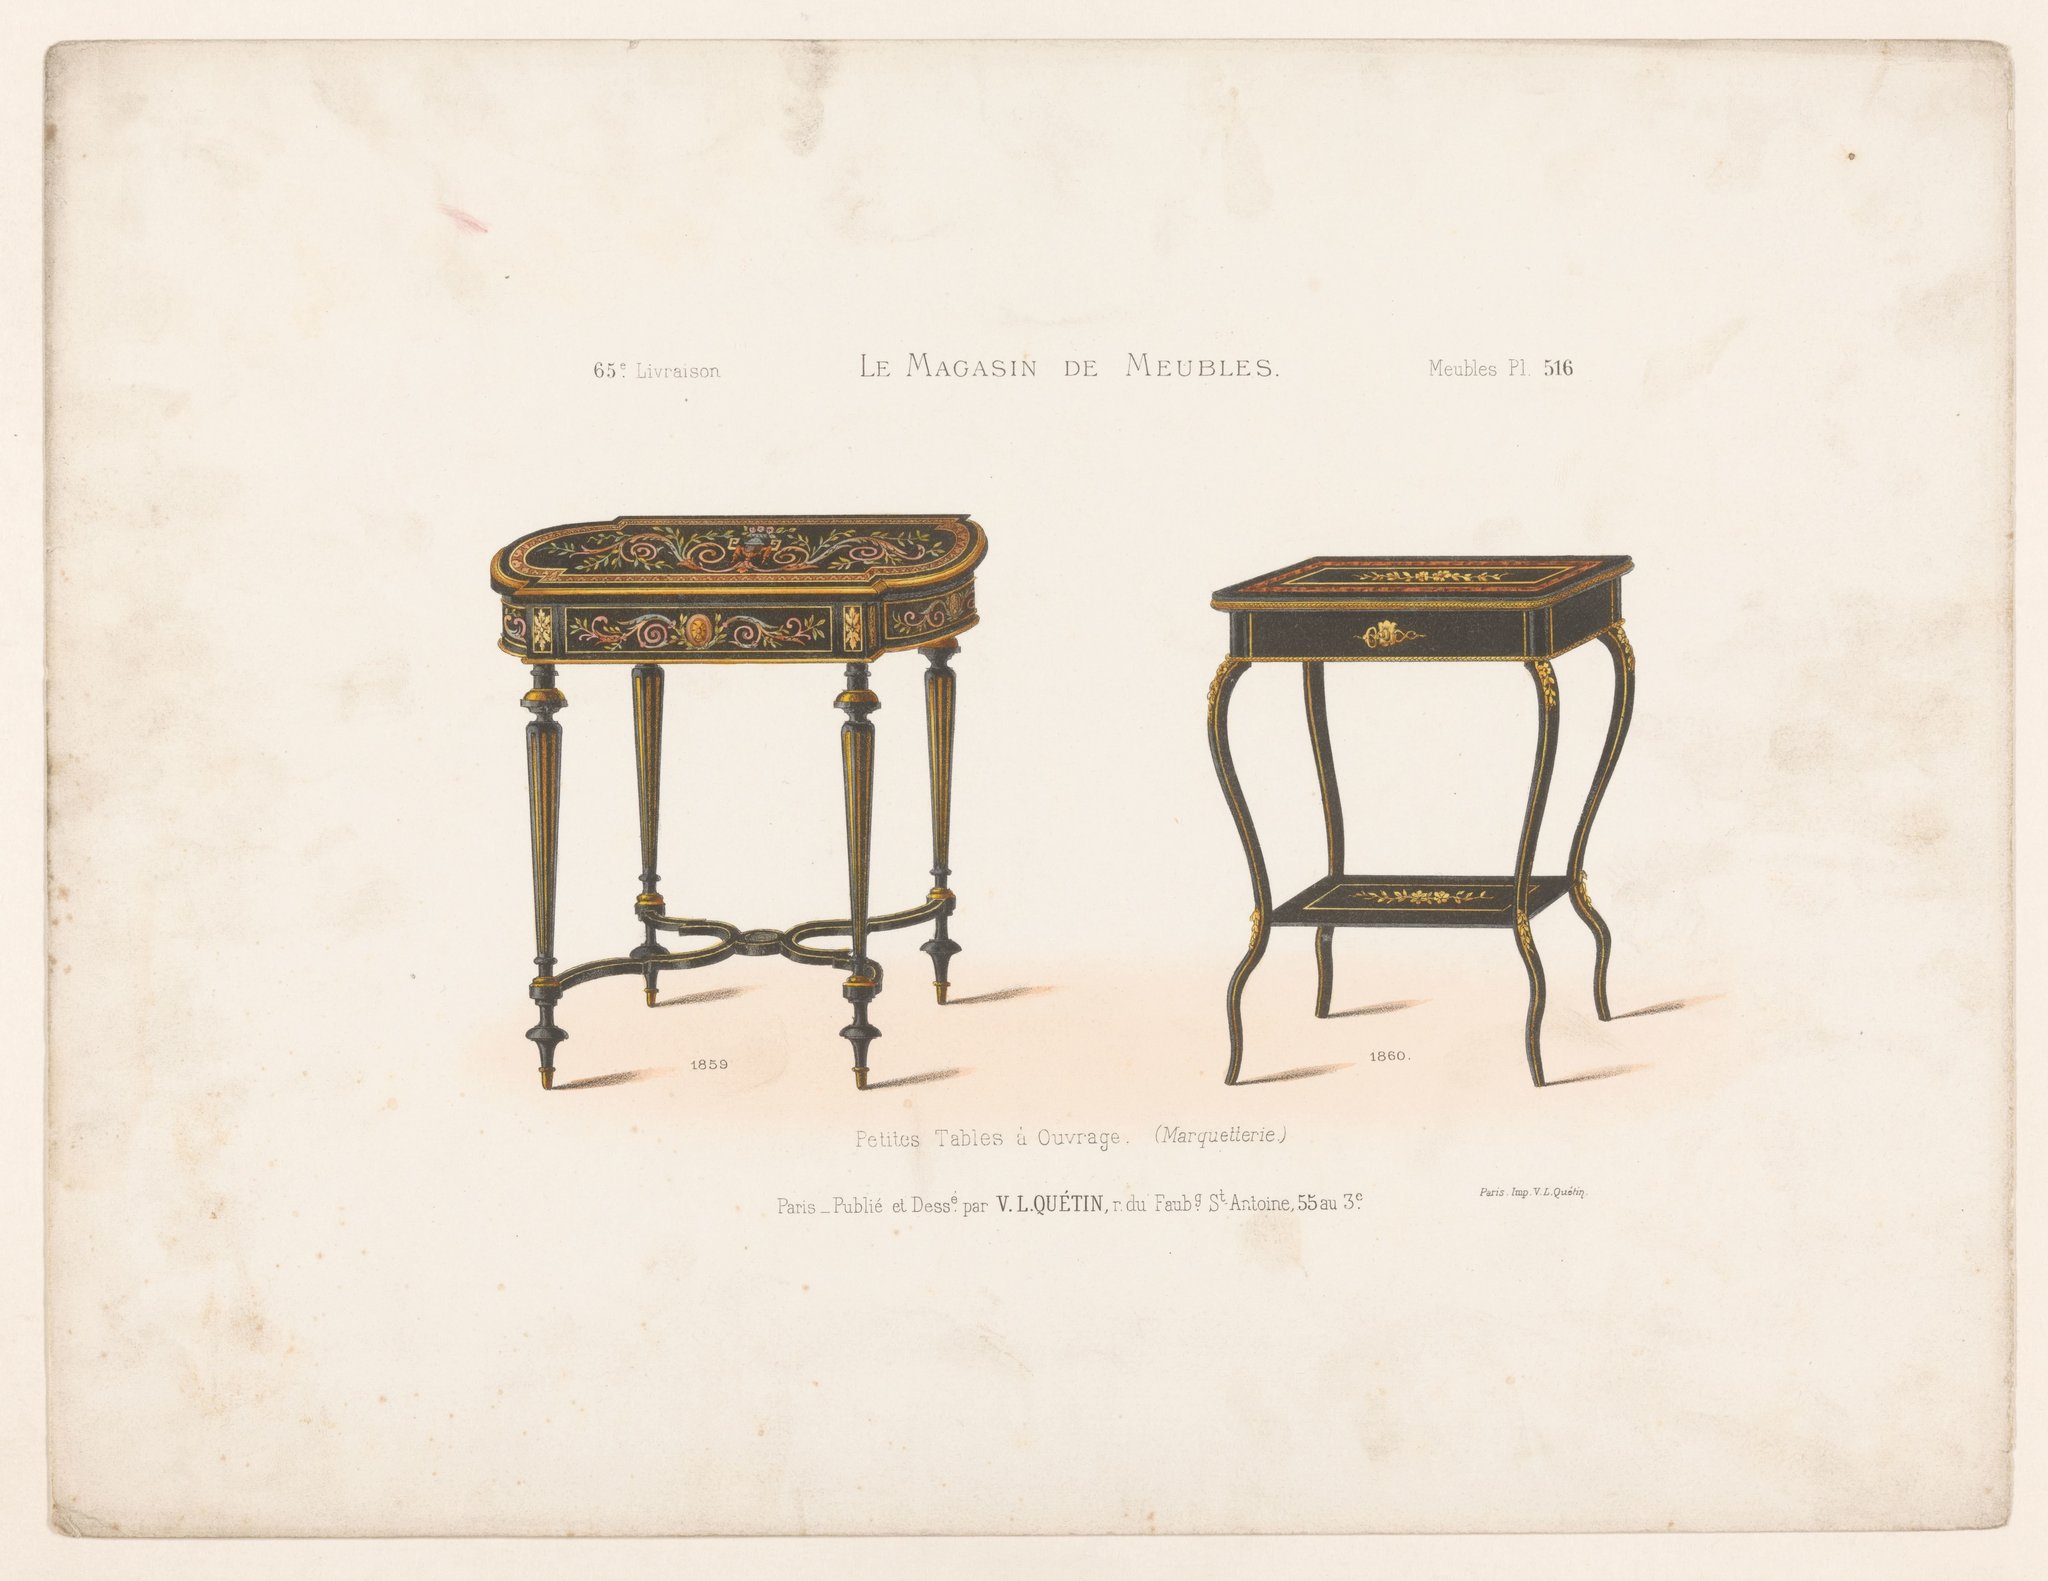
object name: print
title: Twee tafels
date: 1878-1904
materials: paper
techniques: hand coloring, lithograph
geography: paris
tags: table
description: Twee tafels met opklapbaar blad. Prent uit 65e Livraison.